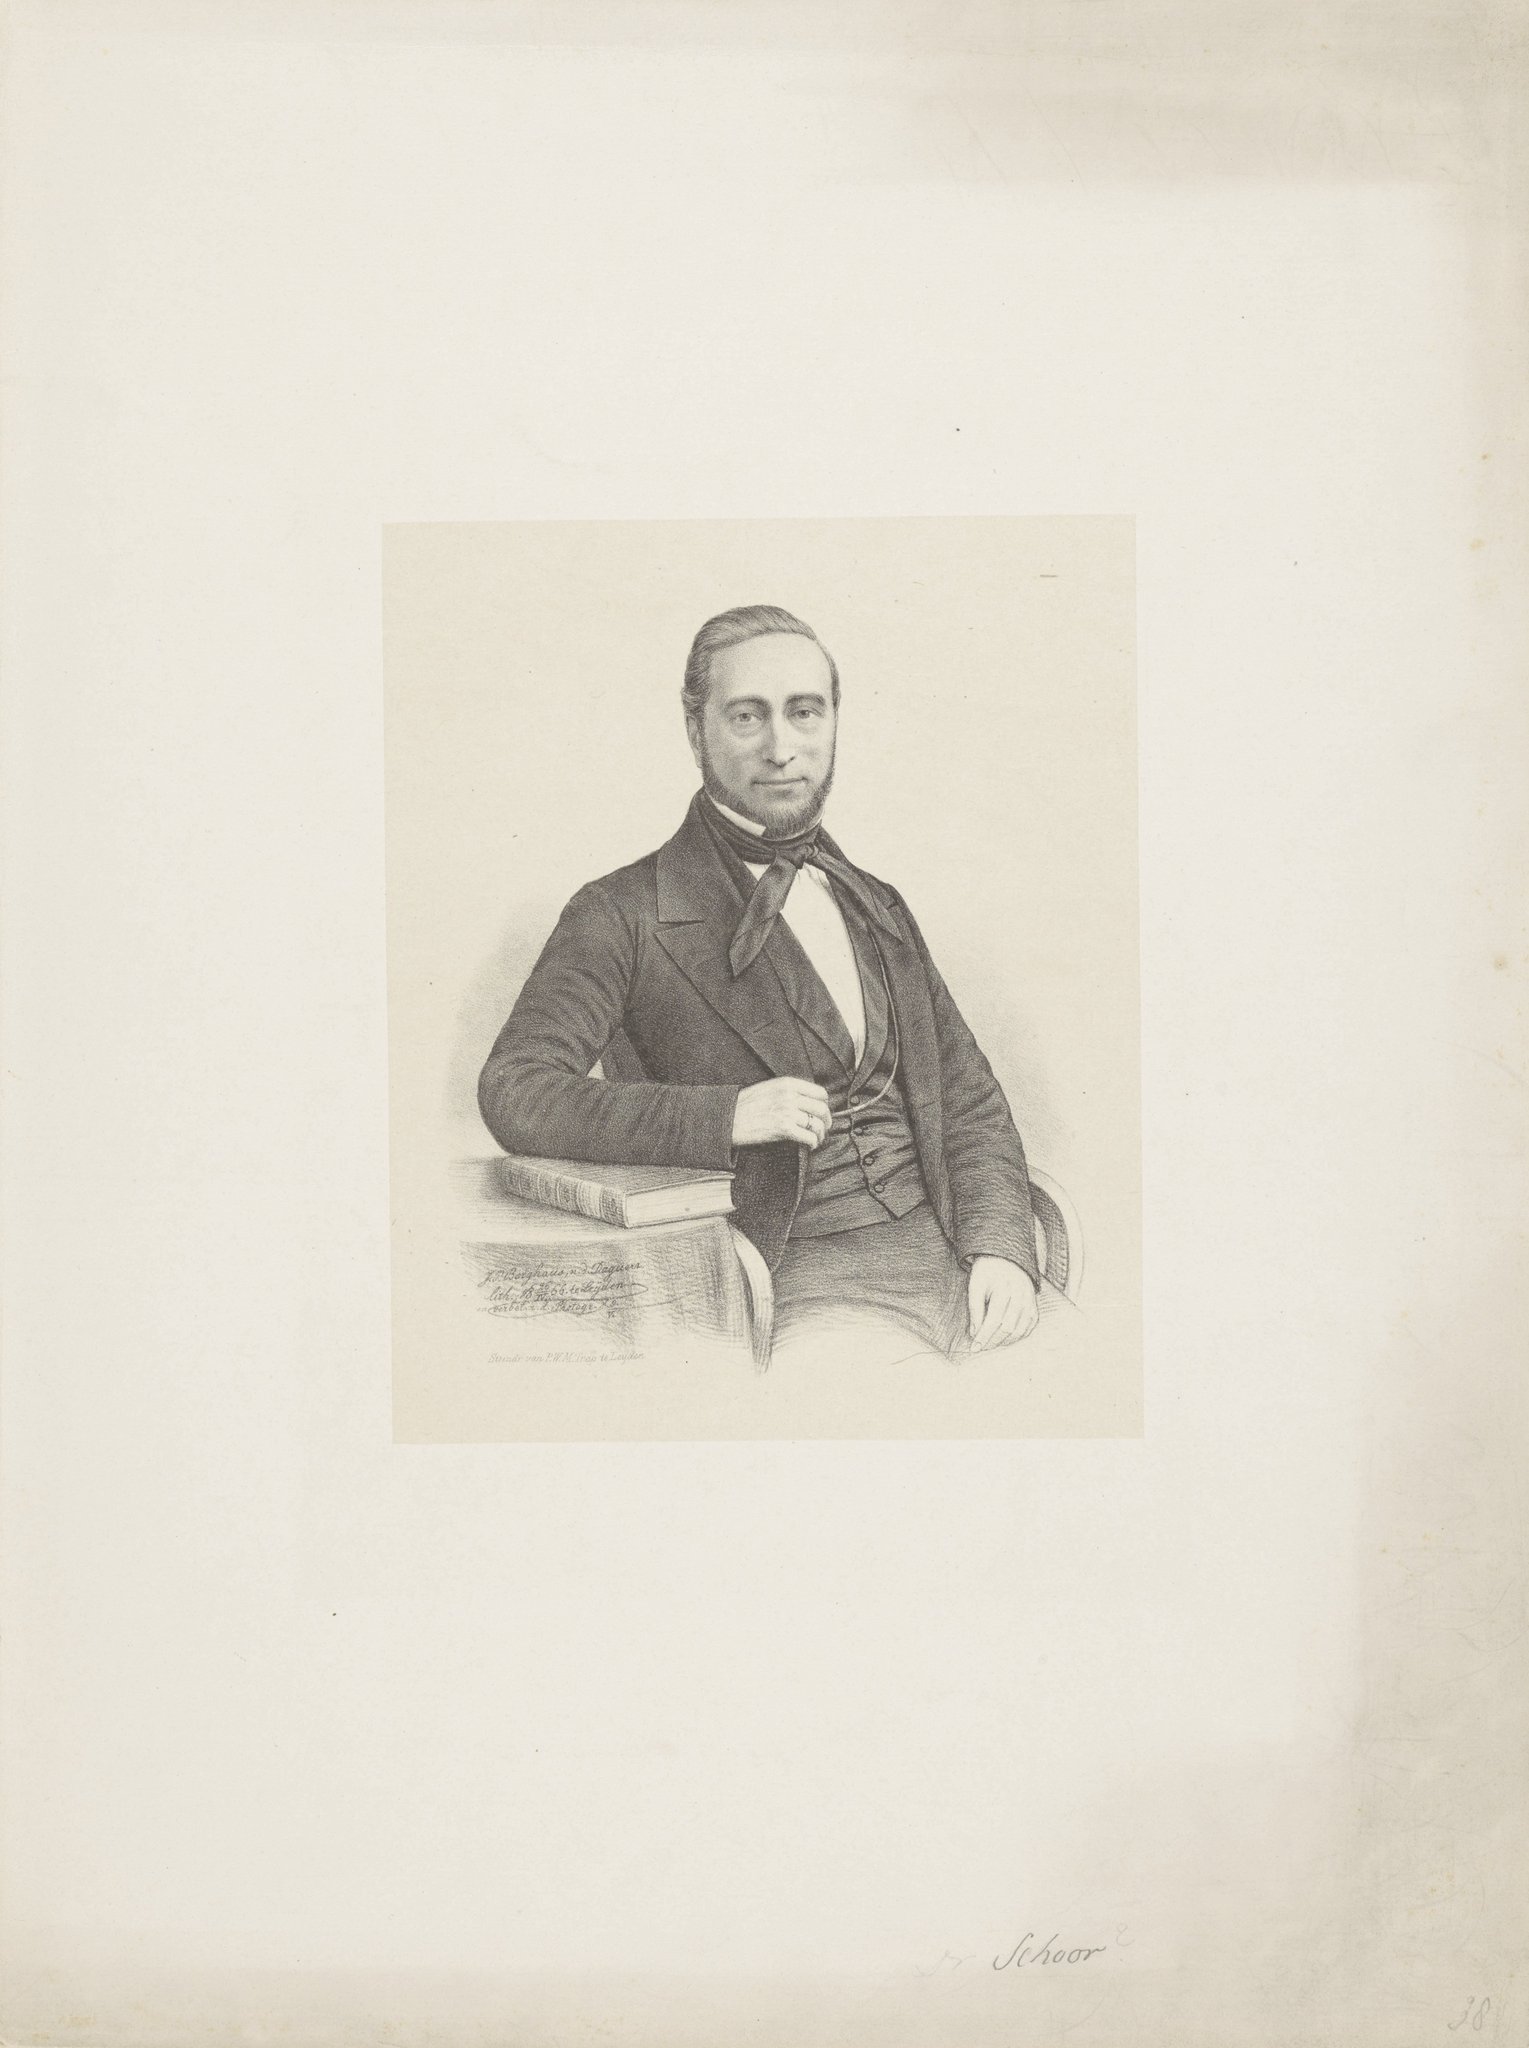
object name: print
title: Portret van H.K.J. Schoor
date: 1866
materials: paper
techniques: lithograph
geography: leiden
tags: historical persons, book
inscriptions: collector's mark: Lugt 2228, inscription: ‘Het aandenken aan / wijlen Dr. H.K.J. Schoor / van zijn weduwe M.C. Ketner / van Pelt / Schiedam November 1866’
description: De geportretteerde zit op een stoel naast een tafel. Met zijn rechterarm leunt hij op een boek dat op tafel ligt.